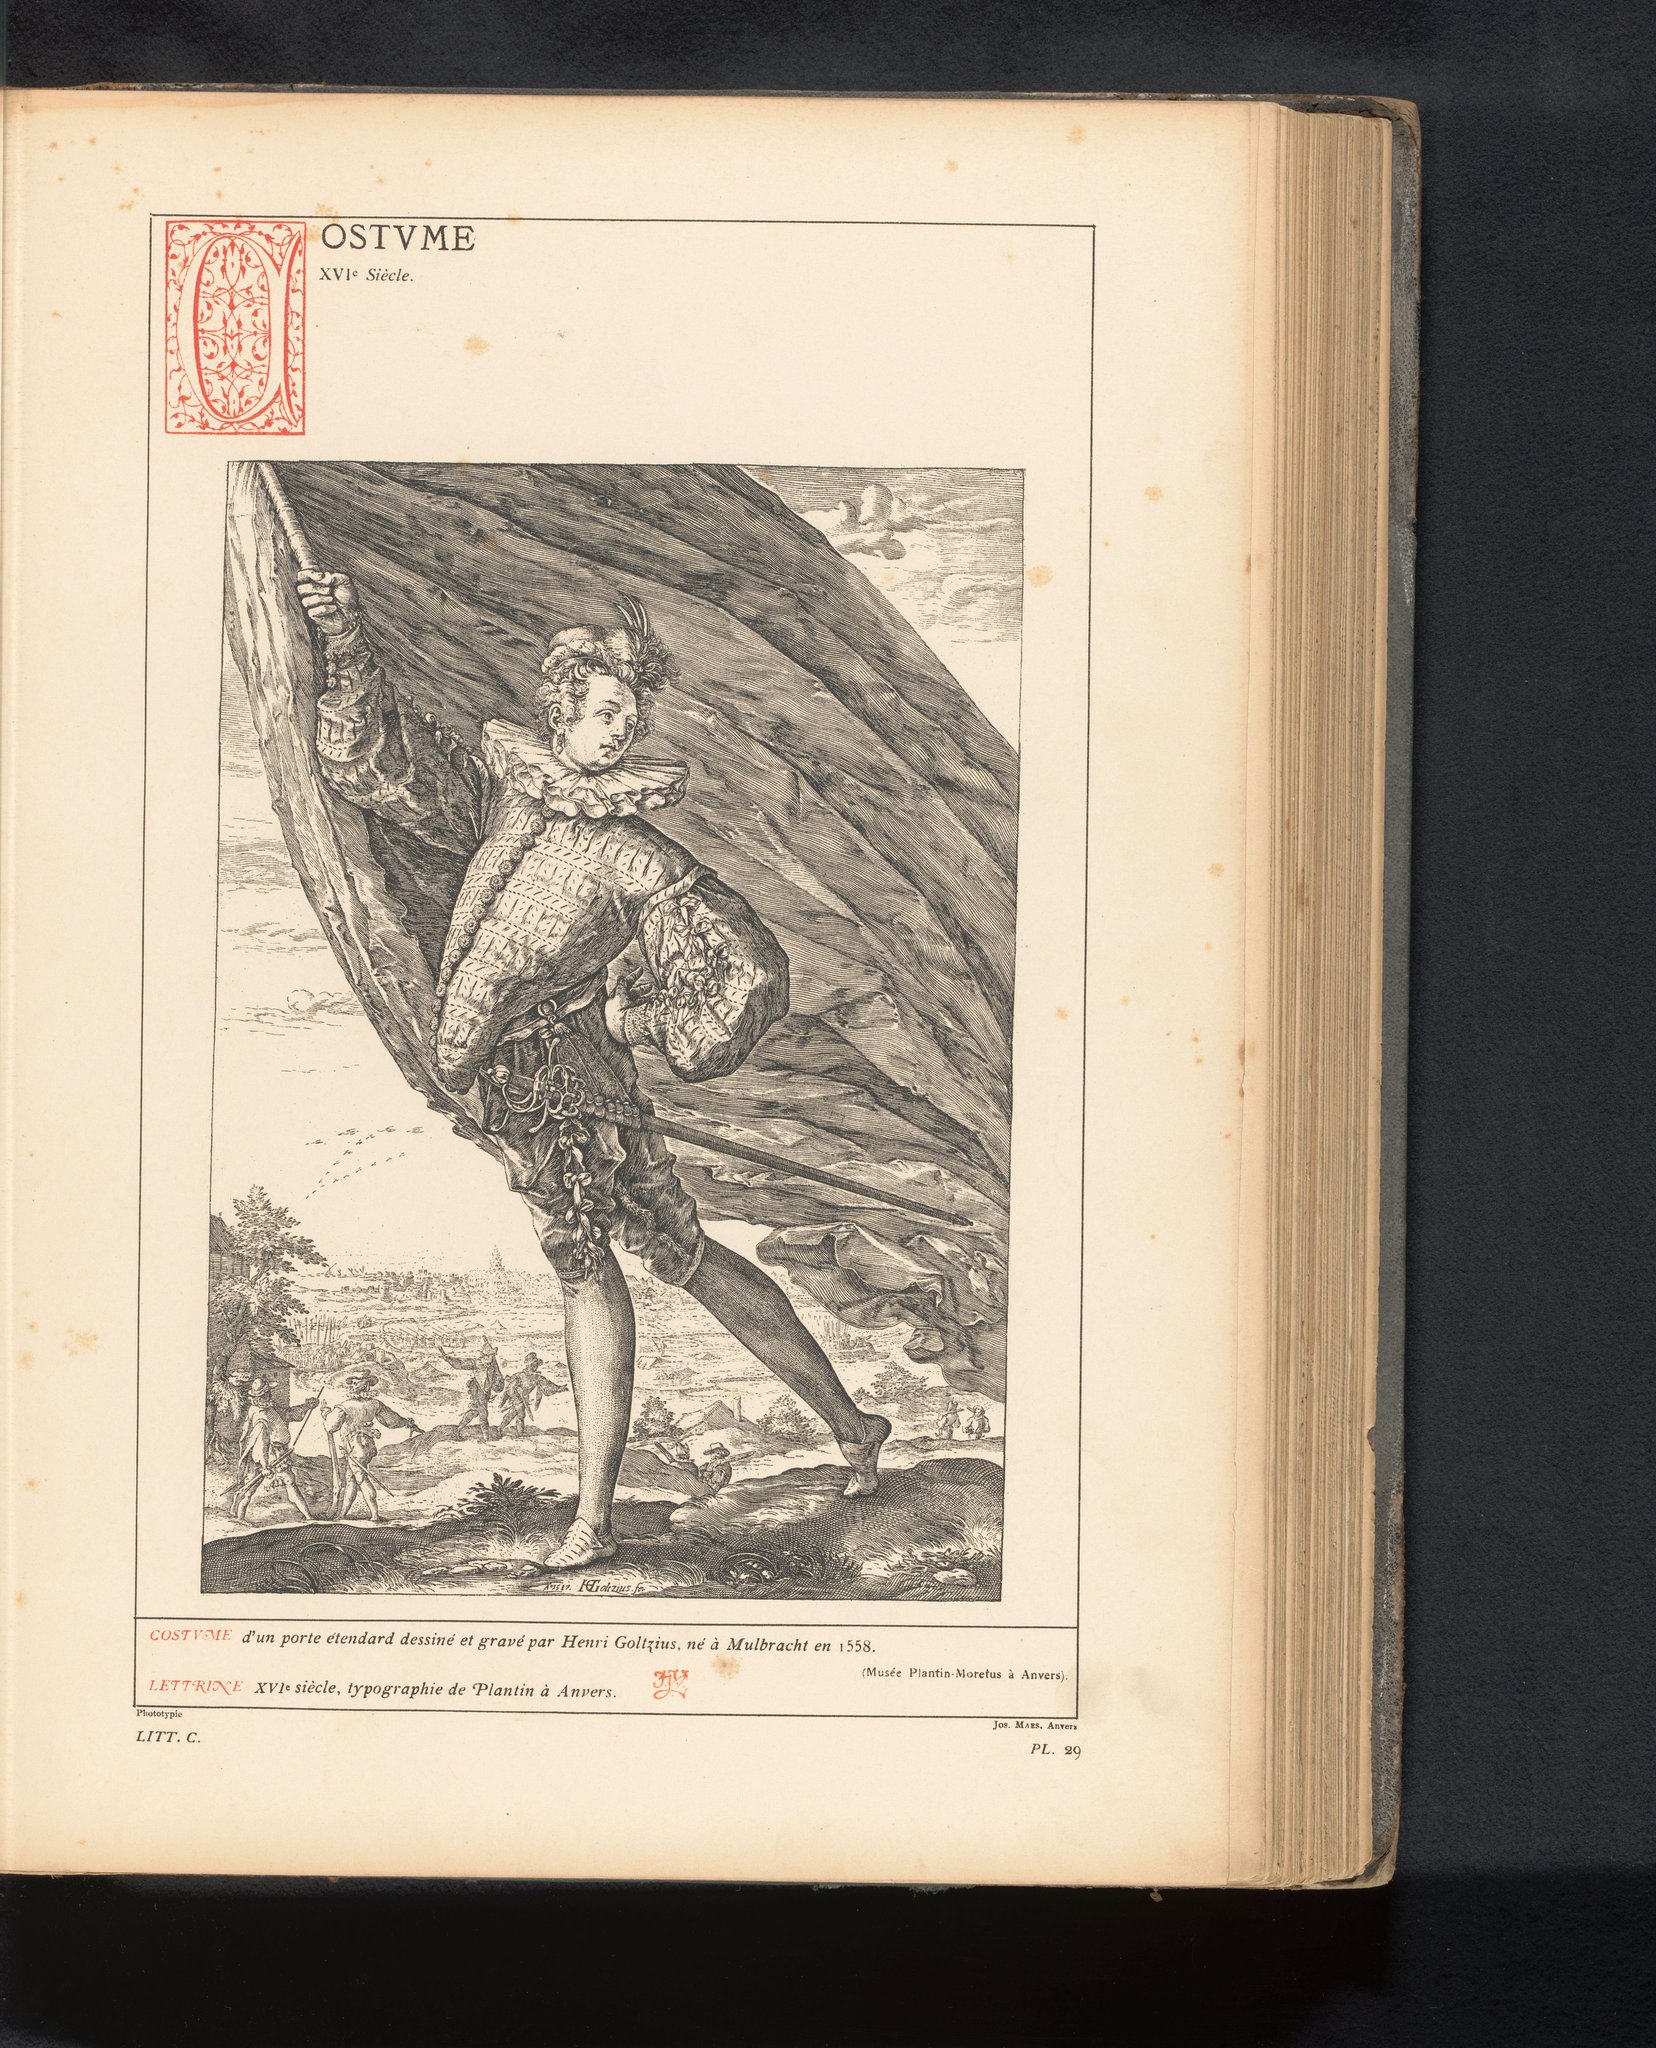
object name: reproduction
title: Reproductie van een prent met officieren met 'ganzenbuiken' door Hendrick Goltzius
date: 1875-1880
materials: paper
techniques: photolithography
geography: antwerp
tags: fashion, clothing, (military) standard-bearer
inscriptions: monogram: ‘JJvY’, inscription: ‘LITT: C. - PL. 29’, inscription: ‘Costume d'un porte (...)’